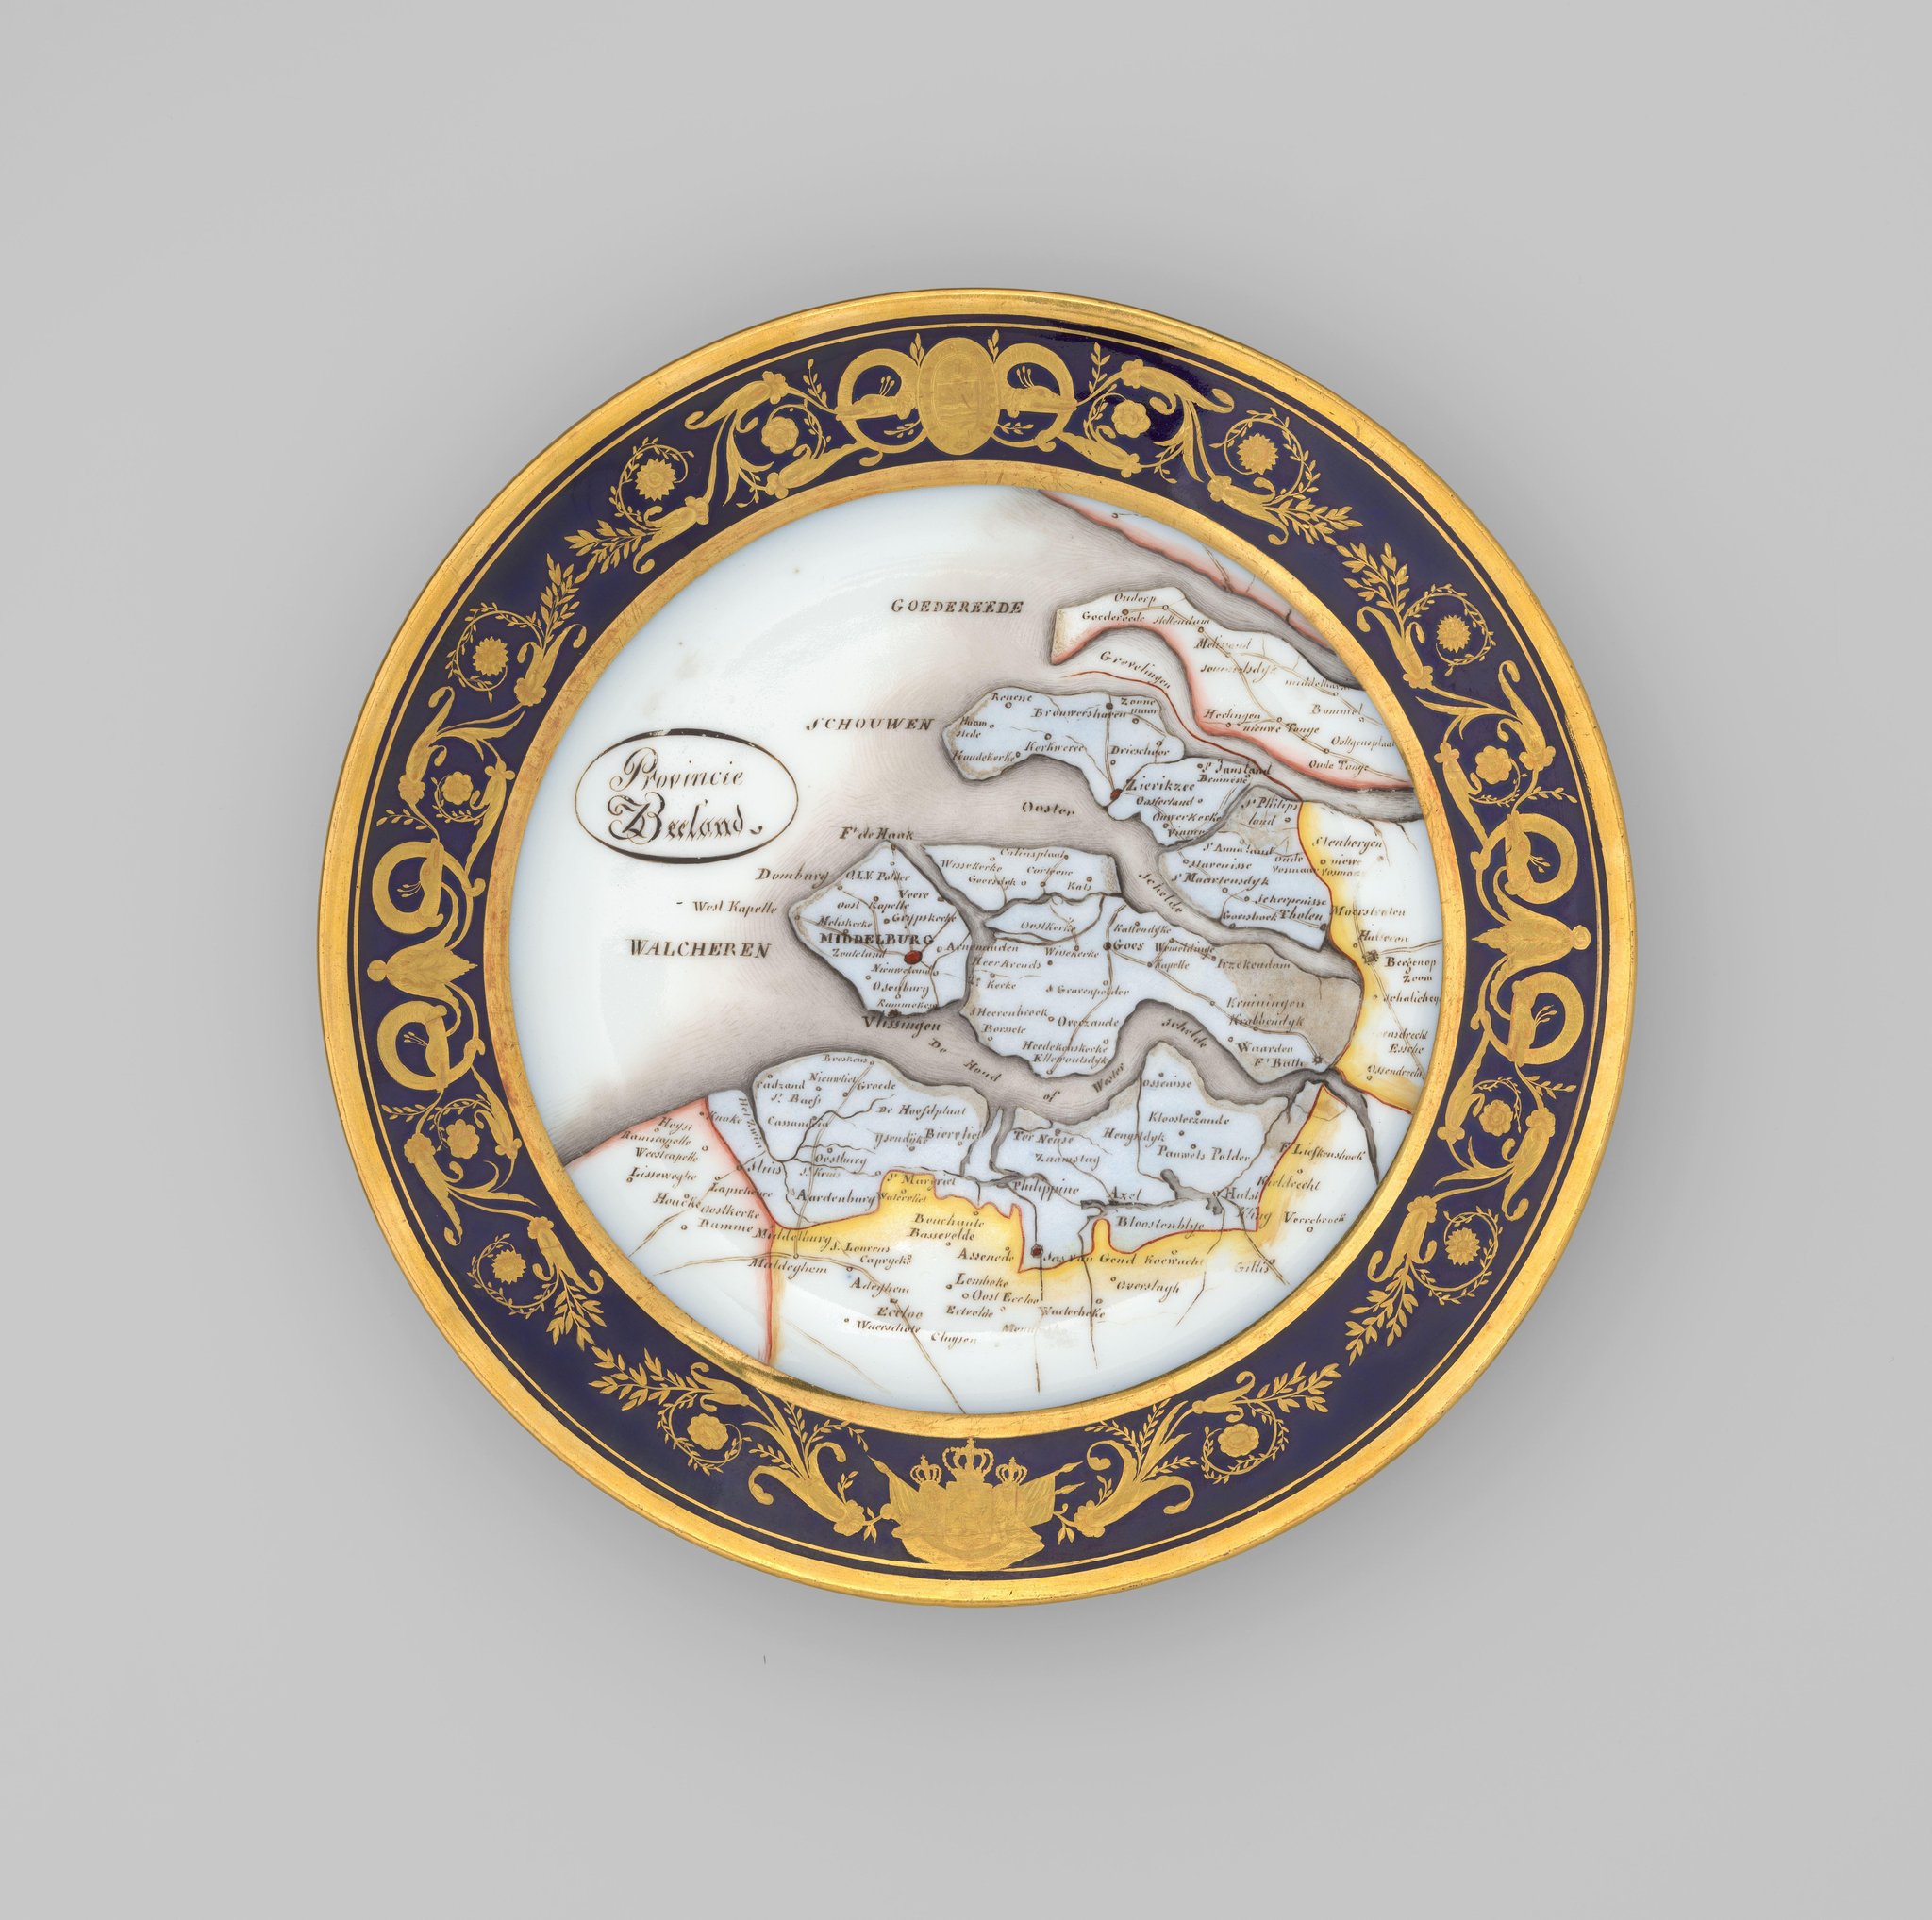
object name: plate dish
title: Plate with a topographical image of the province of Zeeland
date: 1822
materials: glaze, gold, paint, porcelain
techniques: firing, gilding, turning, vitrification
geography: low countries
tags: zeeland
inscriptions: monogram and date: ‘R. D. 1822’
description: These plates reflect the period when the Netherlands and Belgium together formed the United Kingdom of the Netherlands (1815-1830). The kingdom consisted of 17 provinces plus the grand duchy of Luxembourg. The gold decoration is in the Neoclassical style. On the upper edge are the arms of the kingdom, on the lower border those of each province. Today the Netherlands consists of 12 provinces.